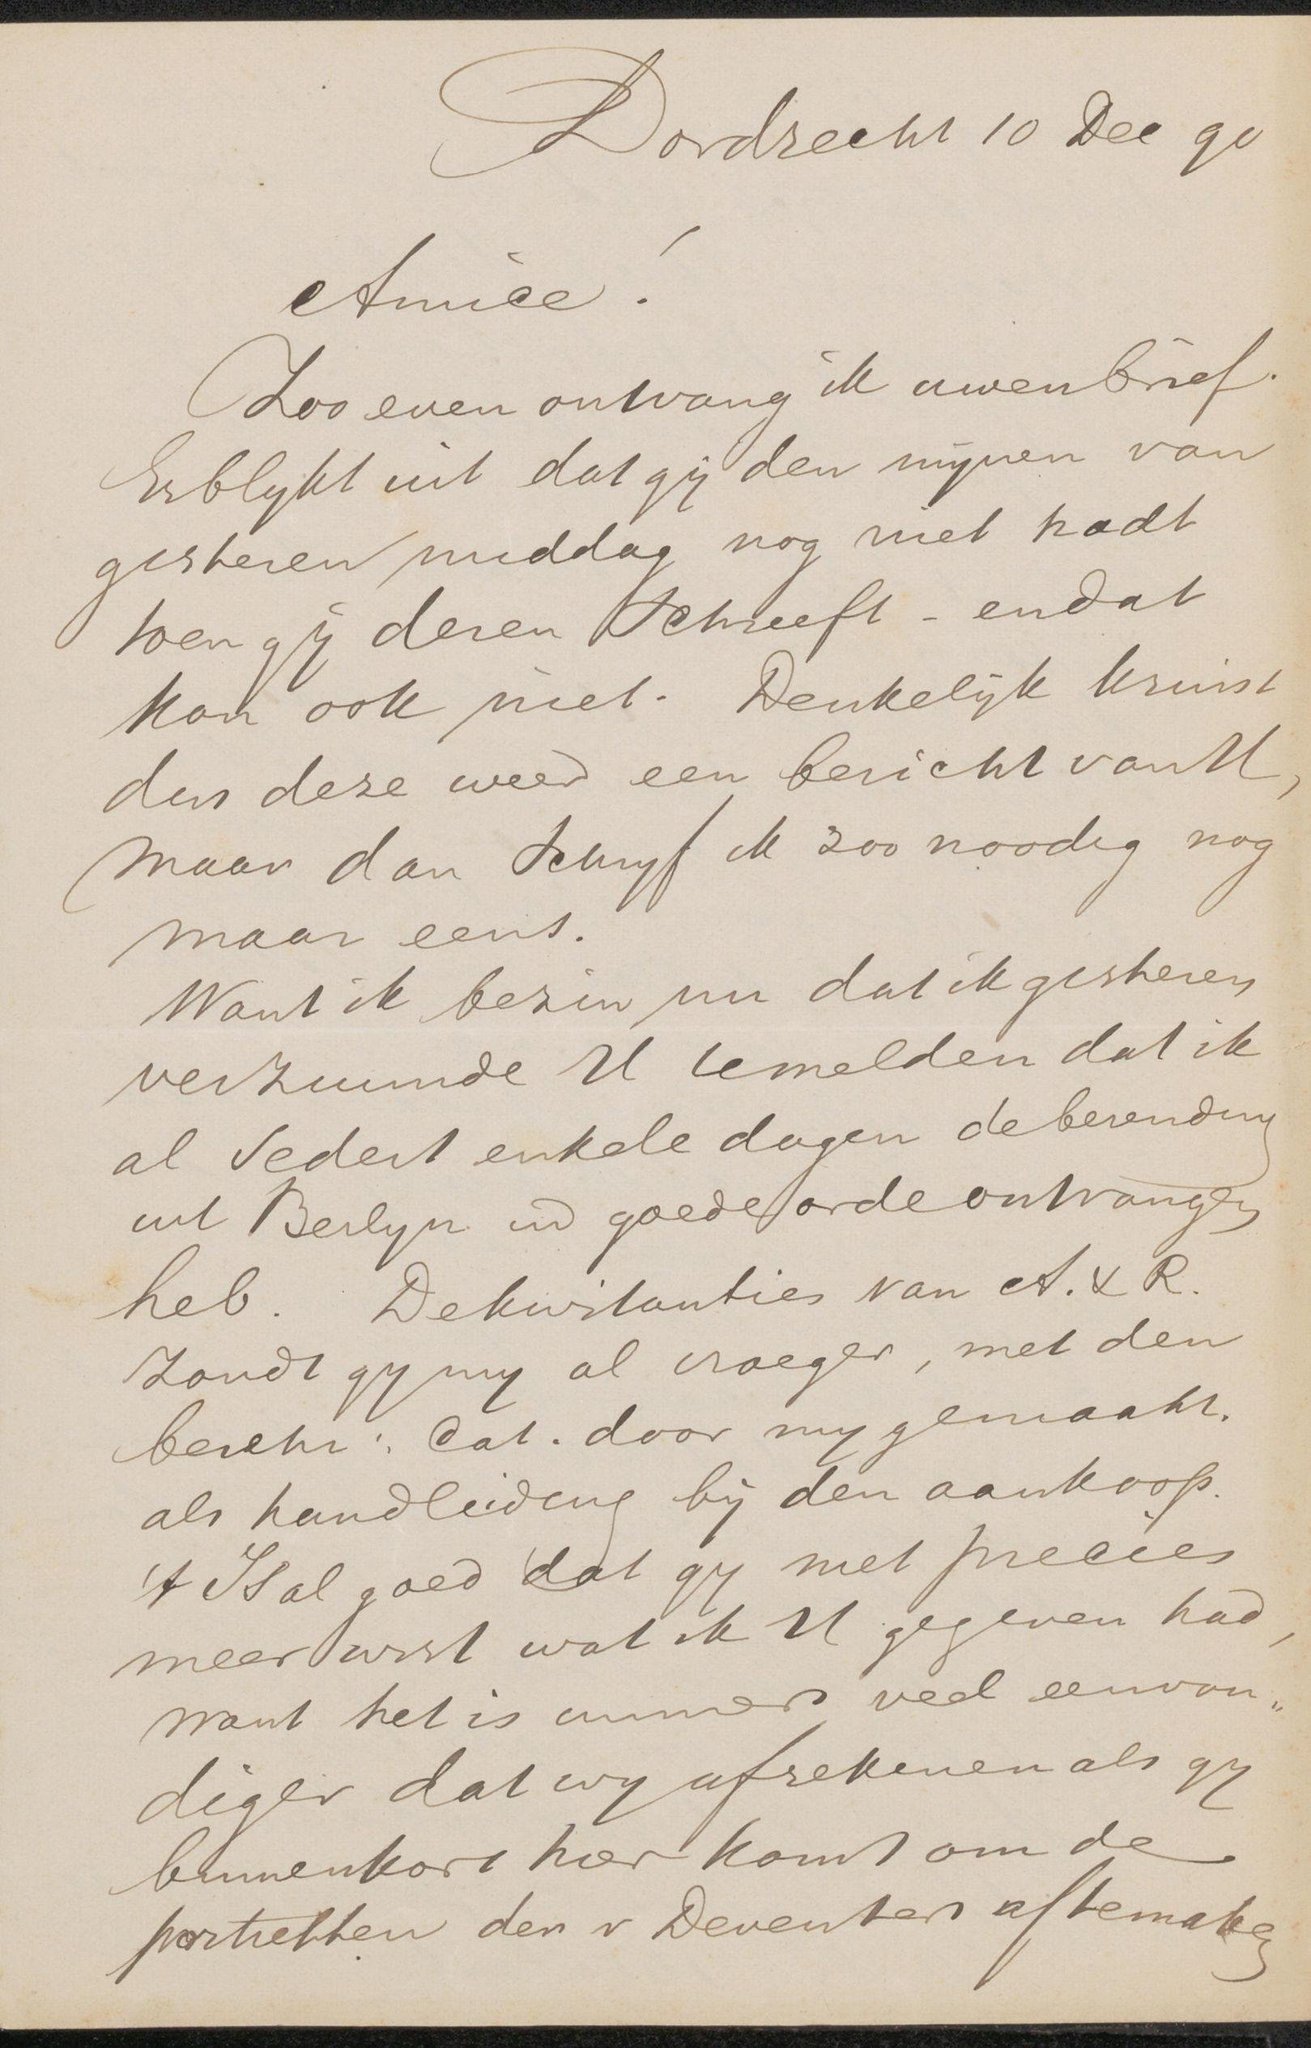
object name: letter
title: Brief aan Jan Veth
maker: martinus cornelis lebret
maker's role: verzamelaar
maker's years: 1833-1894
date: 1890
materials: ink, paper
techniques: pen, writing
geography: dordrecht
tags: rotterdam, george hendrik breitner, dordrecht, amsterdam, painter, print maker, draughtsman, designer, jan veth, chap van deventer, sculptor, ferdinand liebermann, art trade, art shop, historical persons (portraits and scenes from the life), money, berlin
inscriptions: collector's mark: ‘RPK’